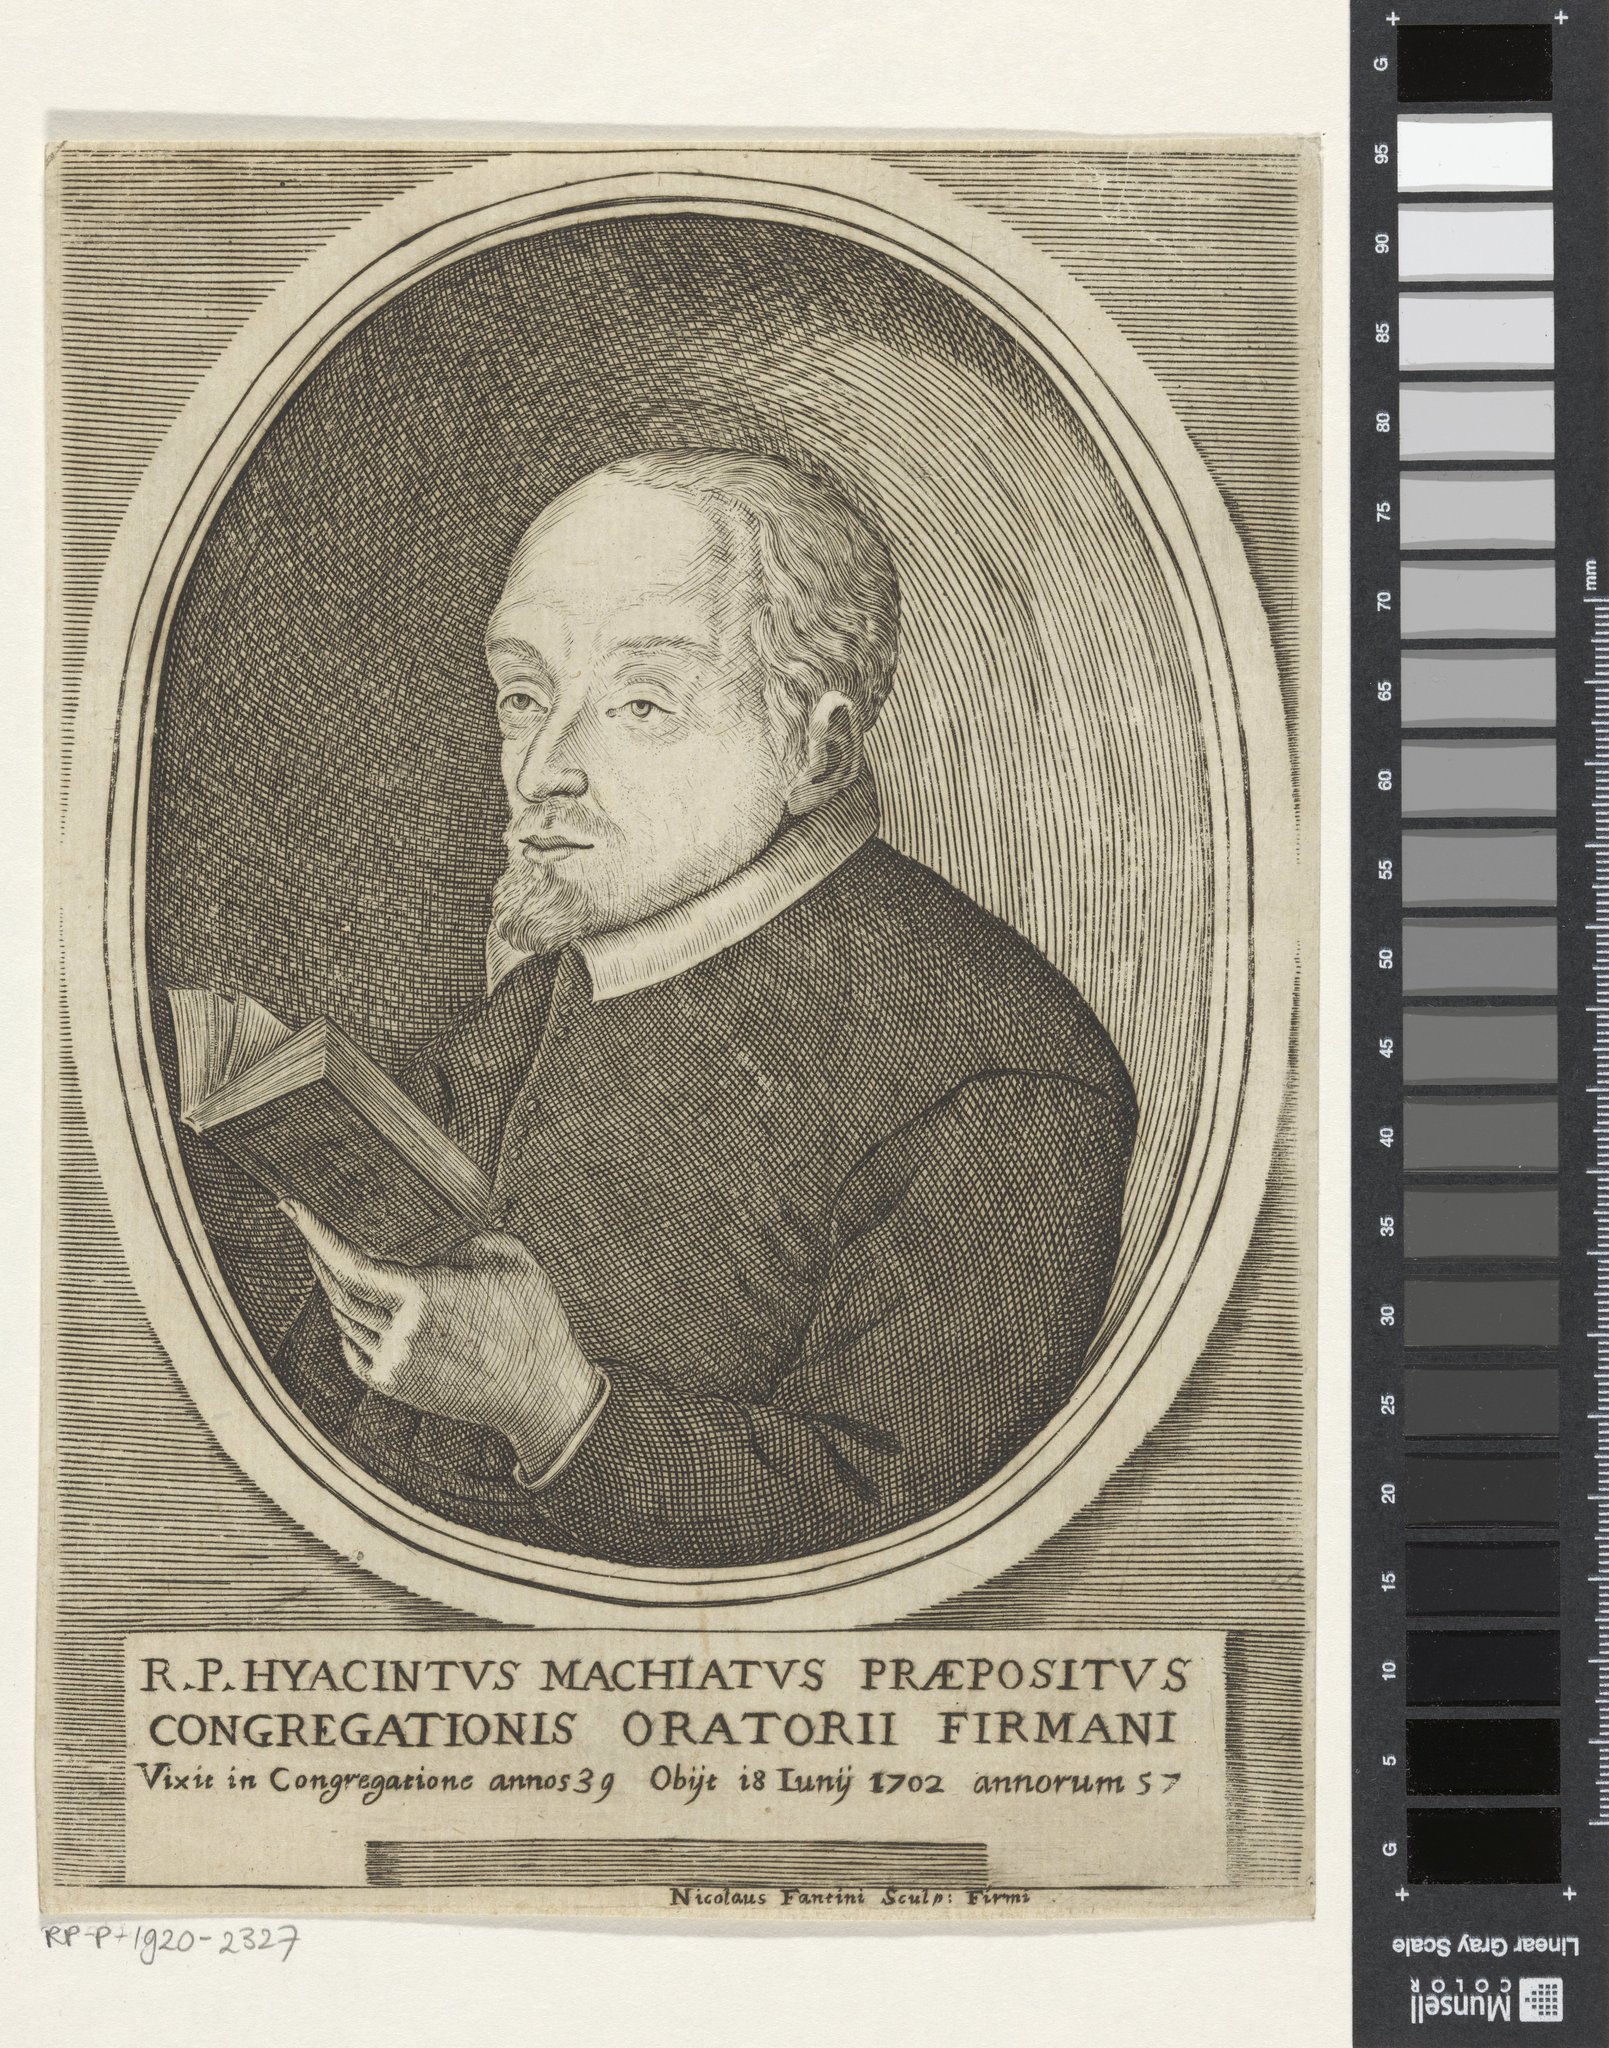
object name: print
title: Portret van geestelijke Hyacintus Machiatus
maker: niccolo fantini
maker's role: print maker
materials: paper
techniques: engraving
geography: italy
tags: historical persons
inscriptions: collector's mark: ‘v b’, collector's mark: Lugt 2228